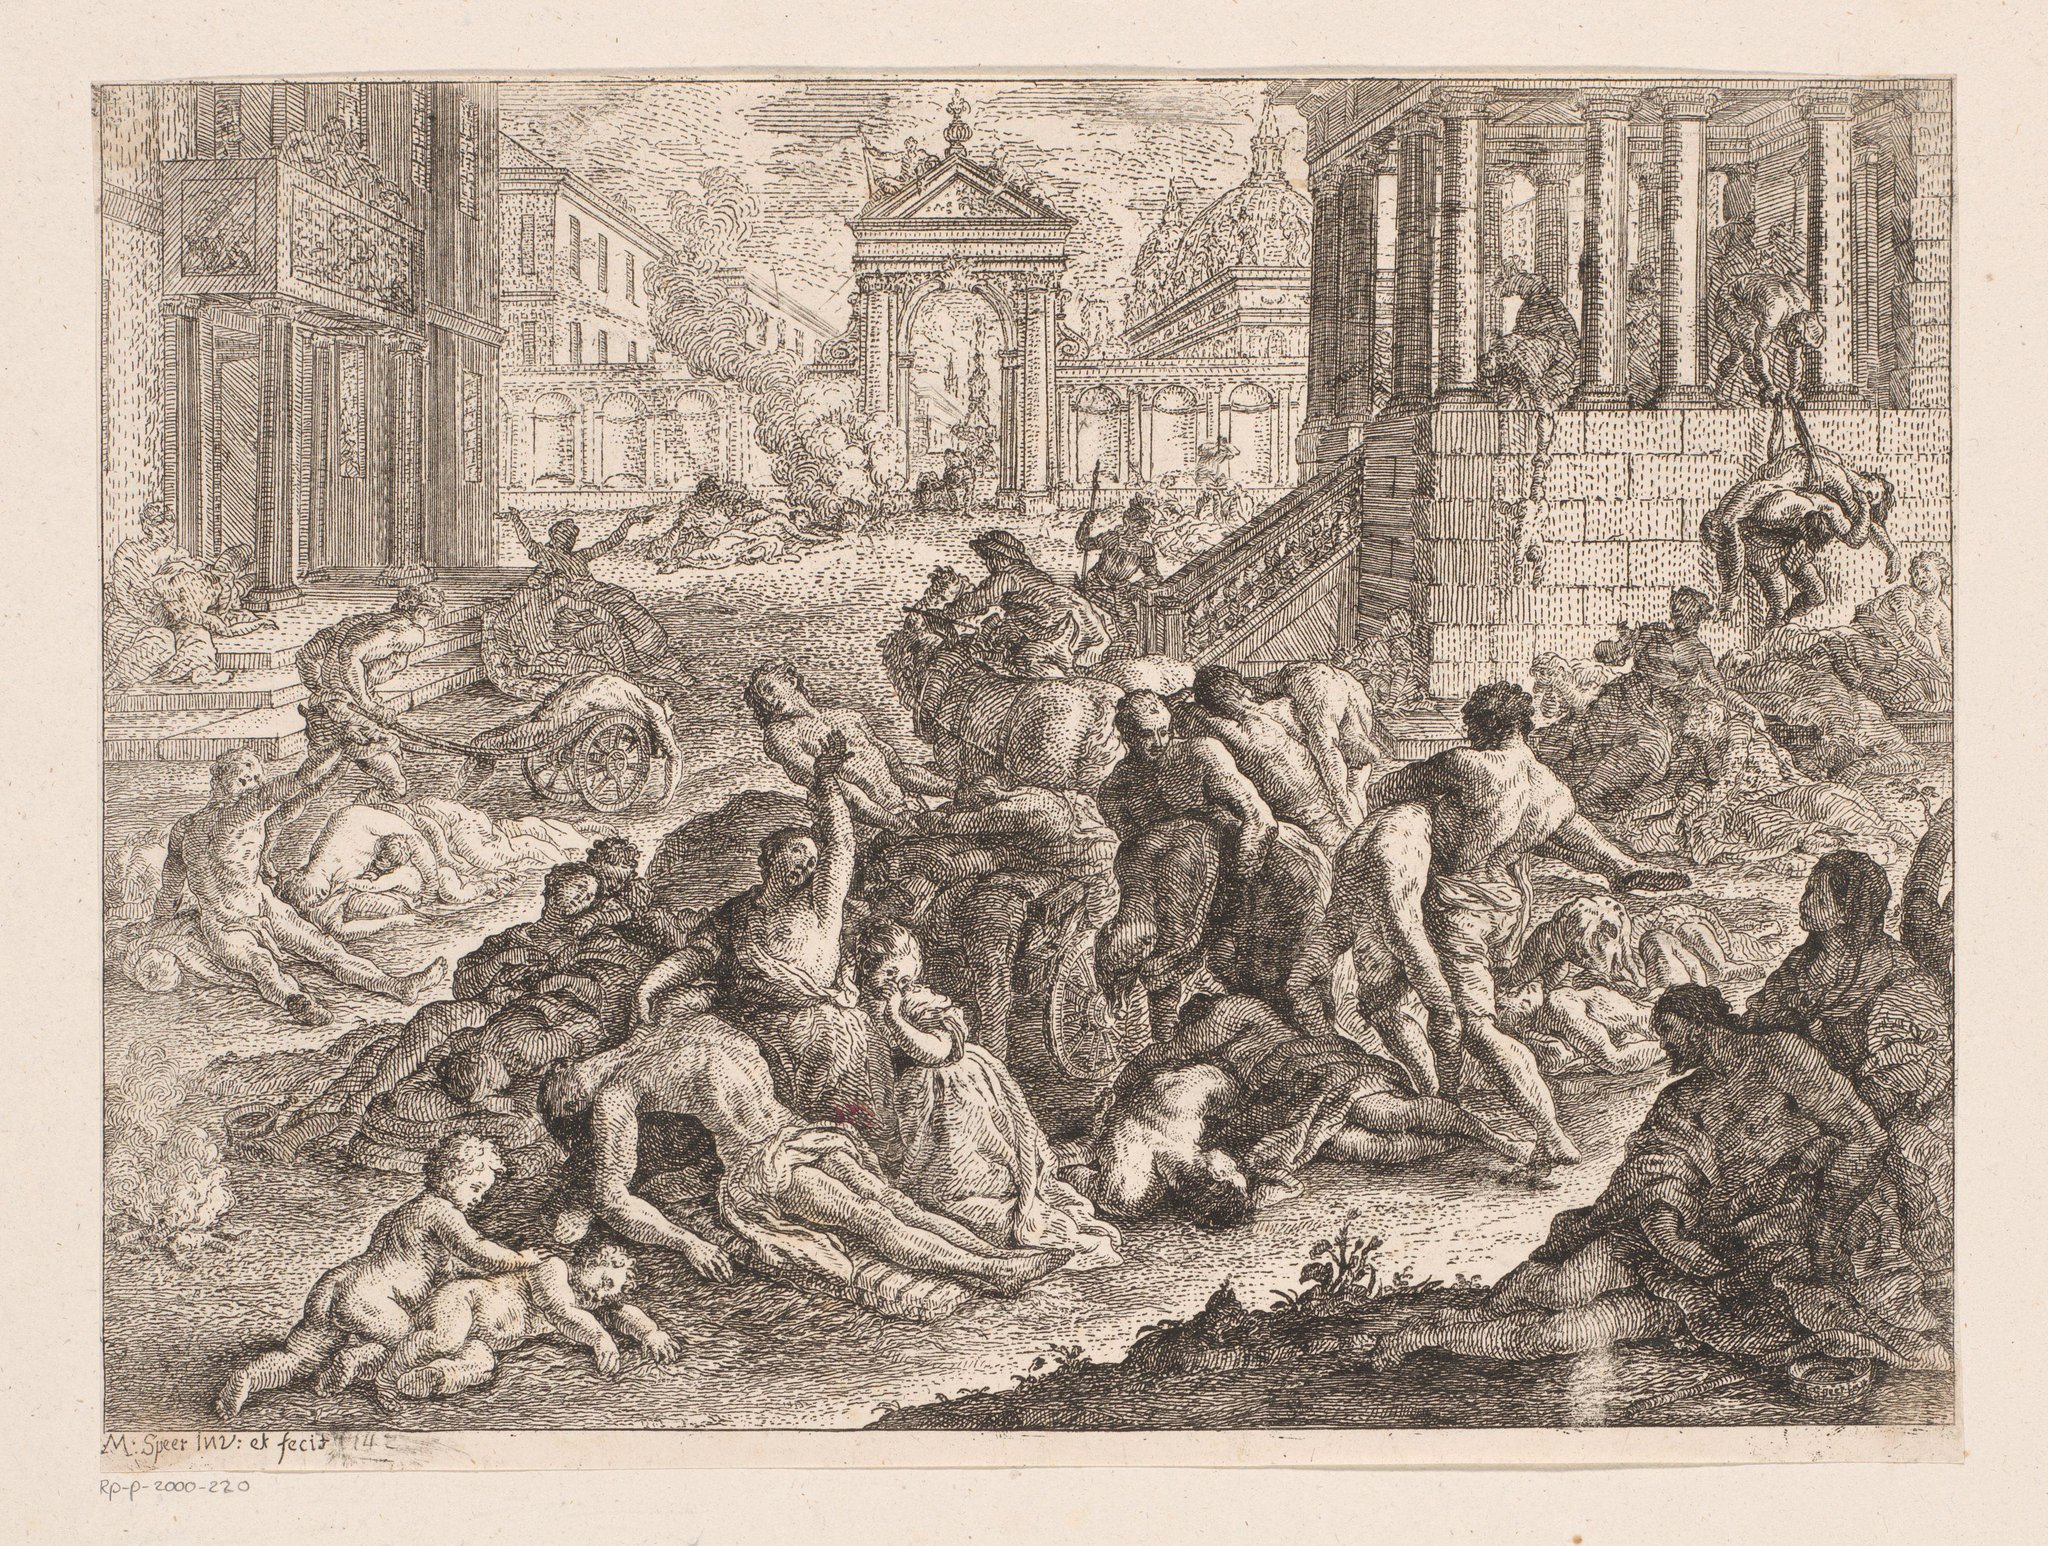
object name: print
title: Pest onder de Filistijnen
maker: martin speer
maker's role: painter, print maker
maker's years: 1702-1765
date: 1742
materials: paper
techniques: etching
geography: regensburg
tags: burial, mass-grave, plague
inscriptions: collector's mark: Lugt 2228, collector's mark: Lugt 2760